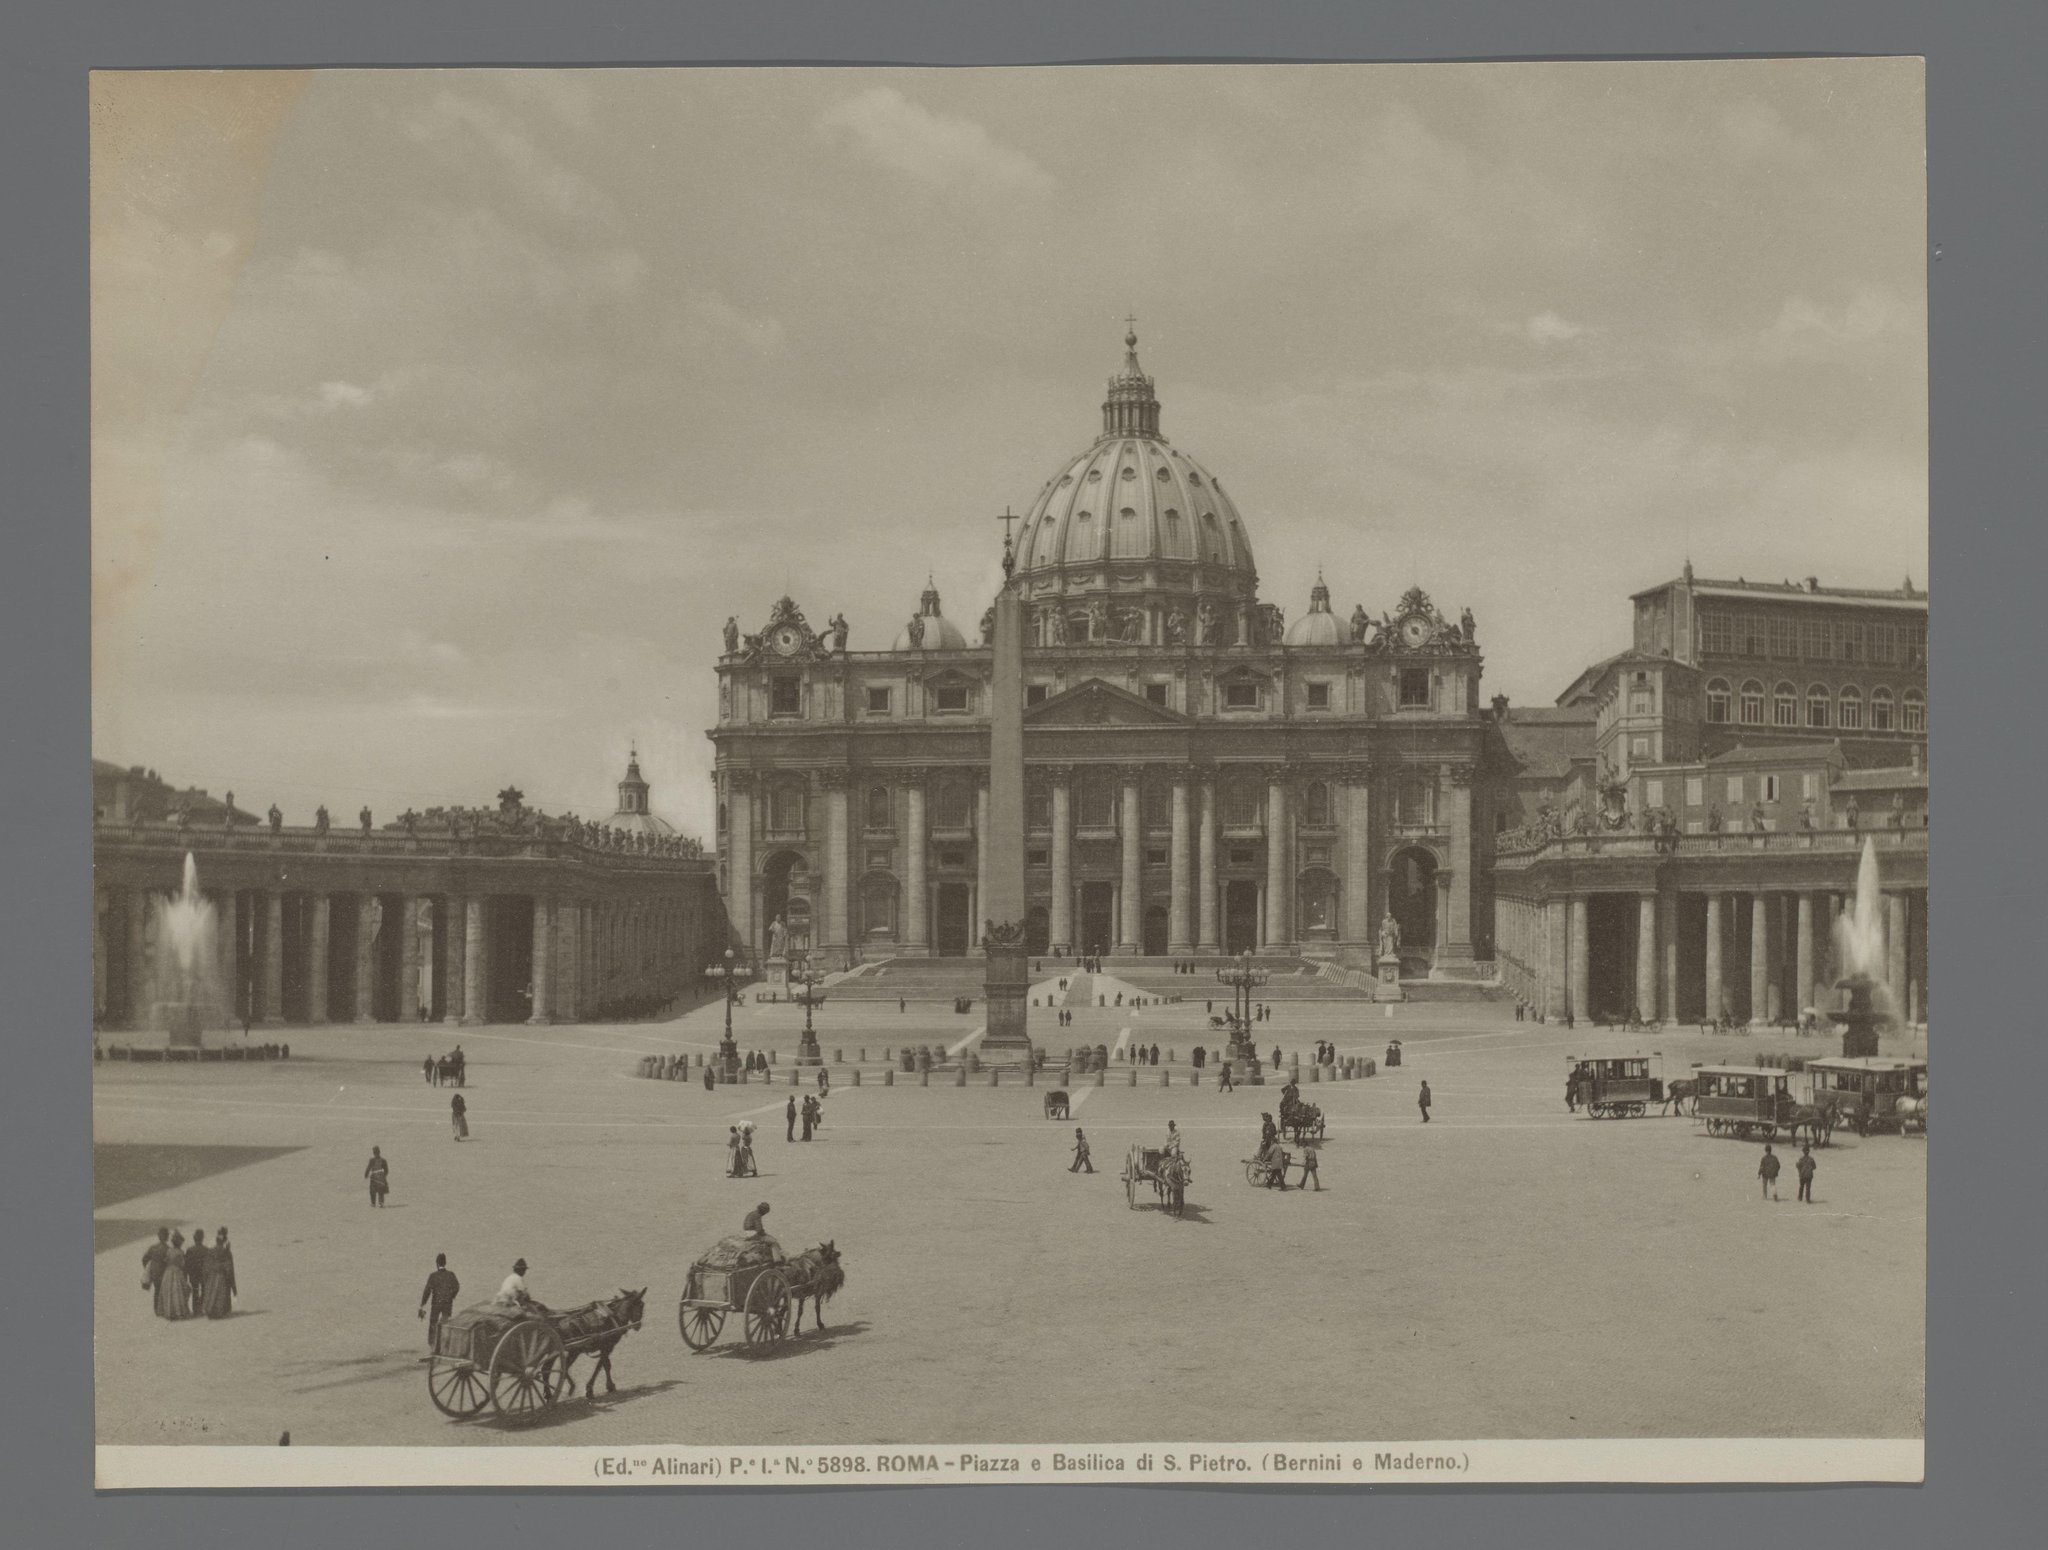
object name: photograph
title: Gezicht op het Sint-Pietersplein en de westgevel van de Sint-Pietersbasiliek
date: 1854-1932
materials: paper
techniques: gelatin silver print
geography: vatican city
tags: square, place, circus, etc., obelisk, needle, church (exterior)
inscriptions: number: ‘P. 1a. No. 5898.’, inscription: ‘M [?]’